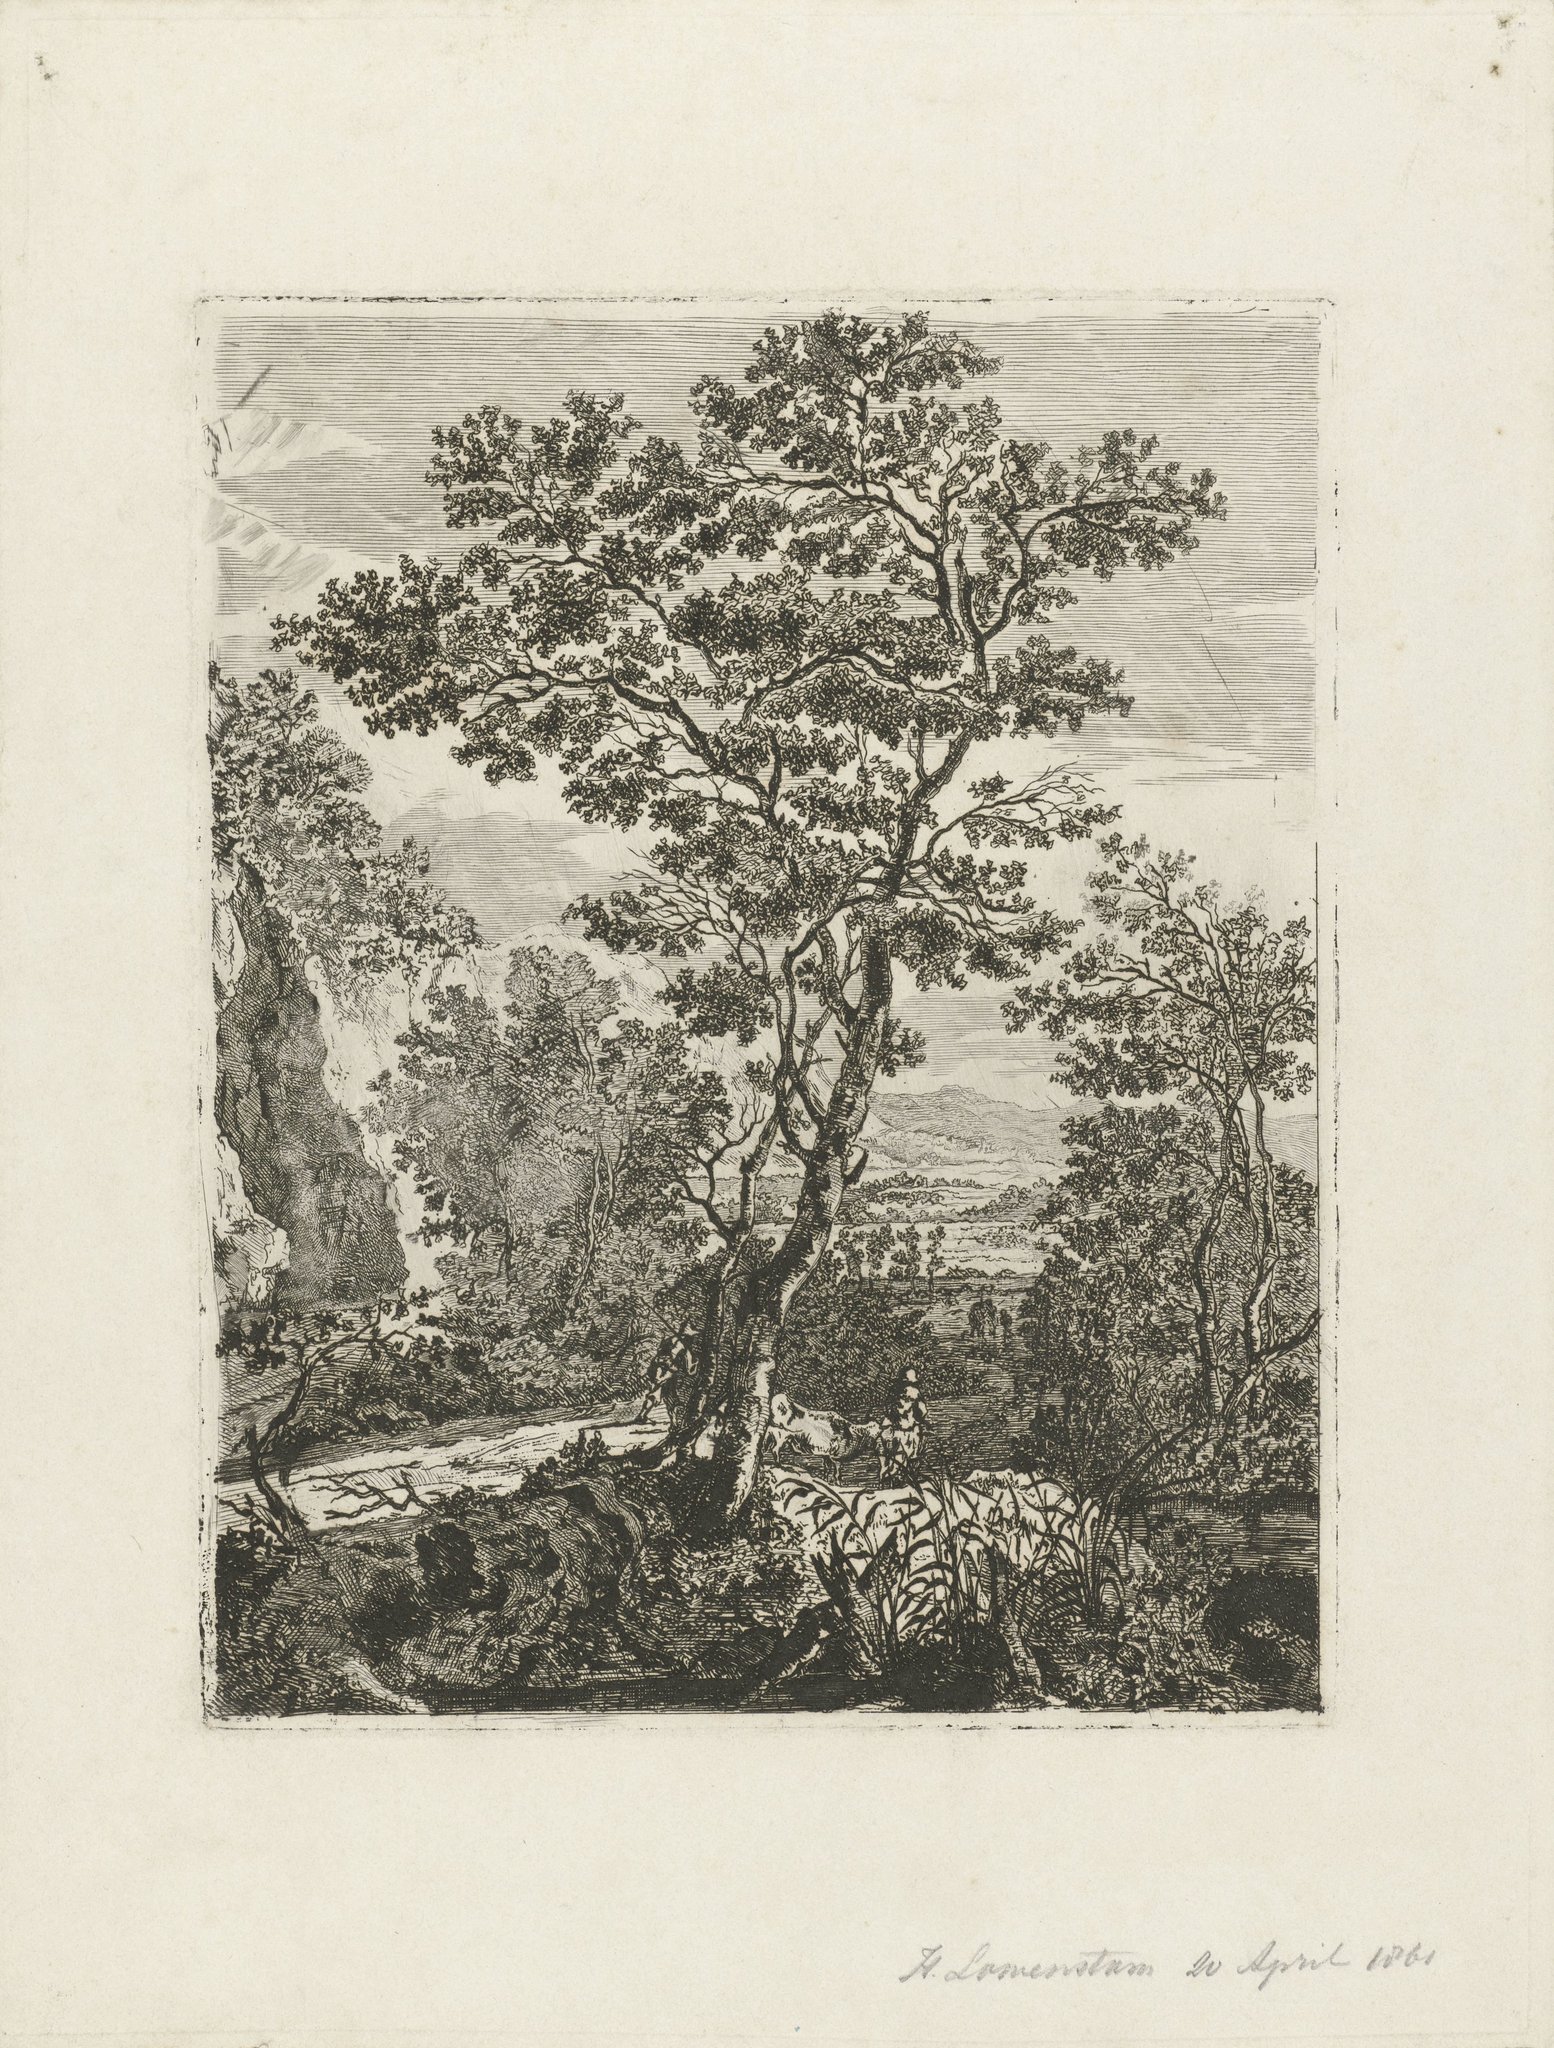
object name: print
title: Italiaans landschap met boeren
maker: herman löwenstam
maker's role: print maker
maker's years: 1840-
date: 1861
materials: paper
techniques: etching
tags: mountains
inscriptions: collector's mark: Lugt 2228, inscription: ‘H. Lowenstam 20 april 1861’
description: Italiaans landschap met twee boeren en een koe.